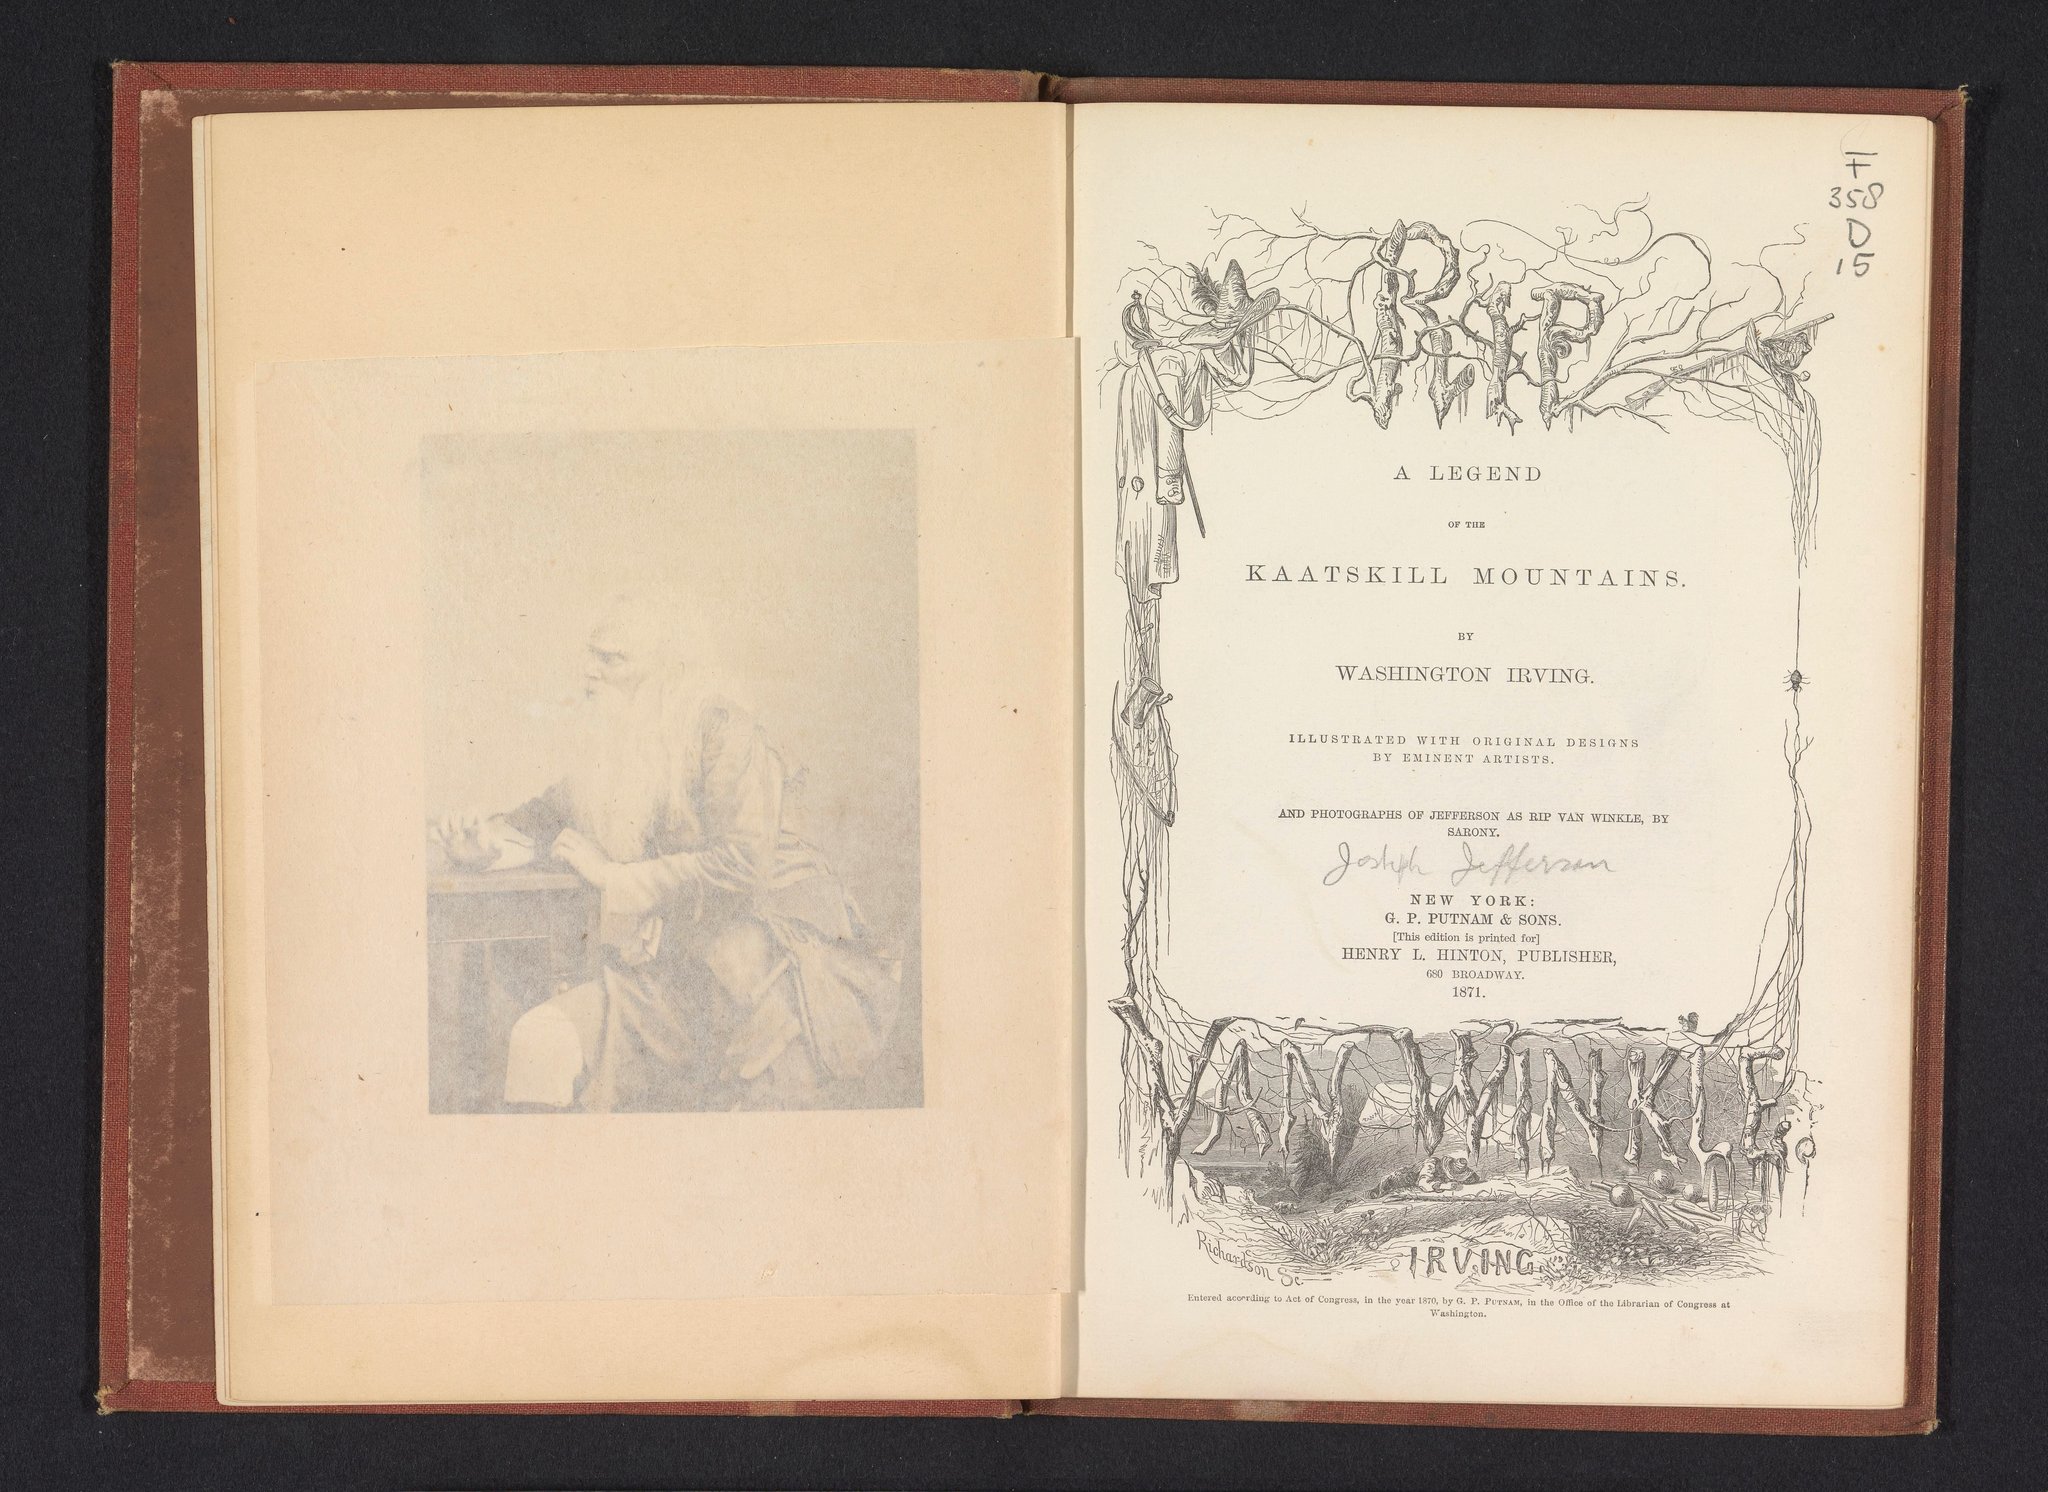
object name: book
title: Rip van Winkle a legend of the Kaatskill Mountains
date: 1871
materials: cardboard, linen, paper, photographic support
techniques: albumen print, carbon print, printing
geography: new york city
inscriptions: name: ‘Presented to [...] Le[...]ie Lea. By her Cousin Louisa + Leonie Ro[...] Jan. et 1873’